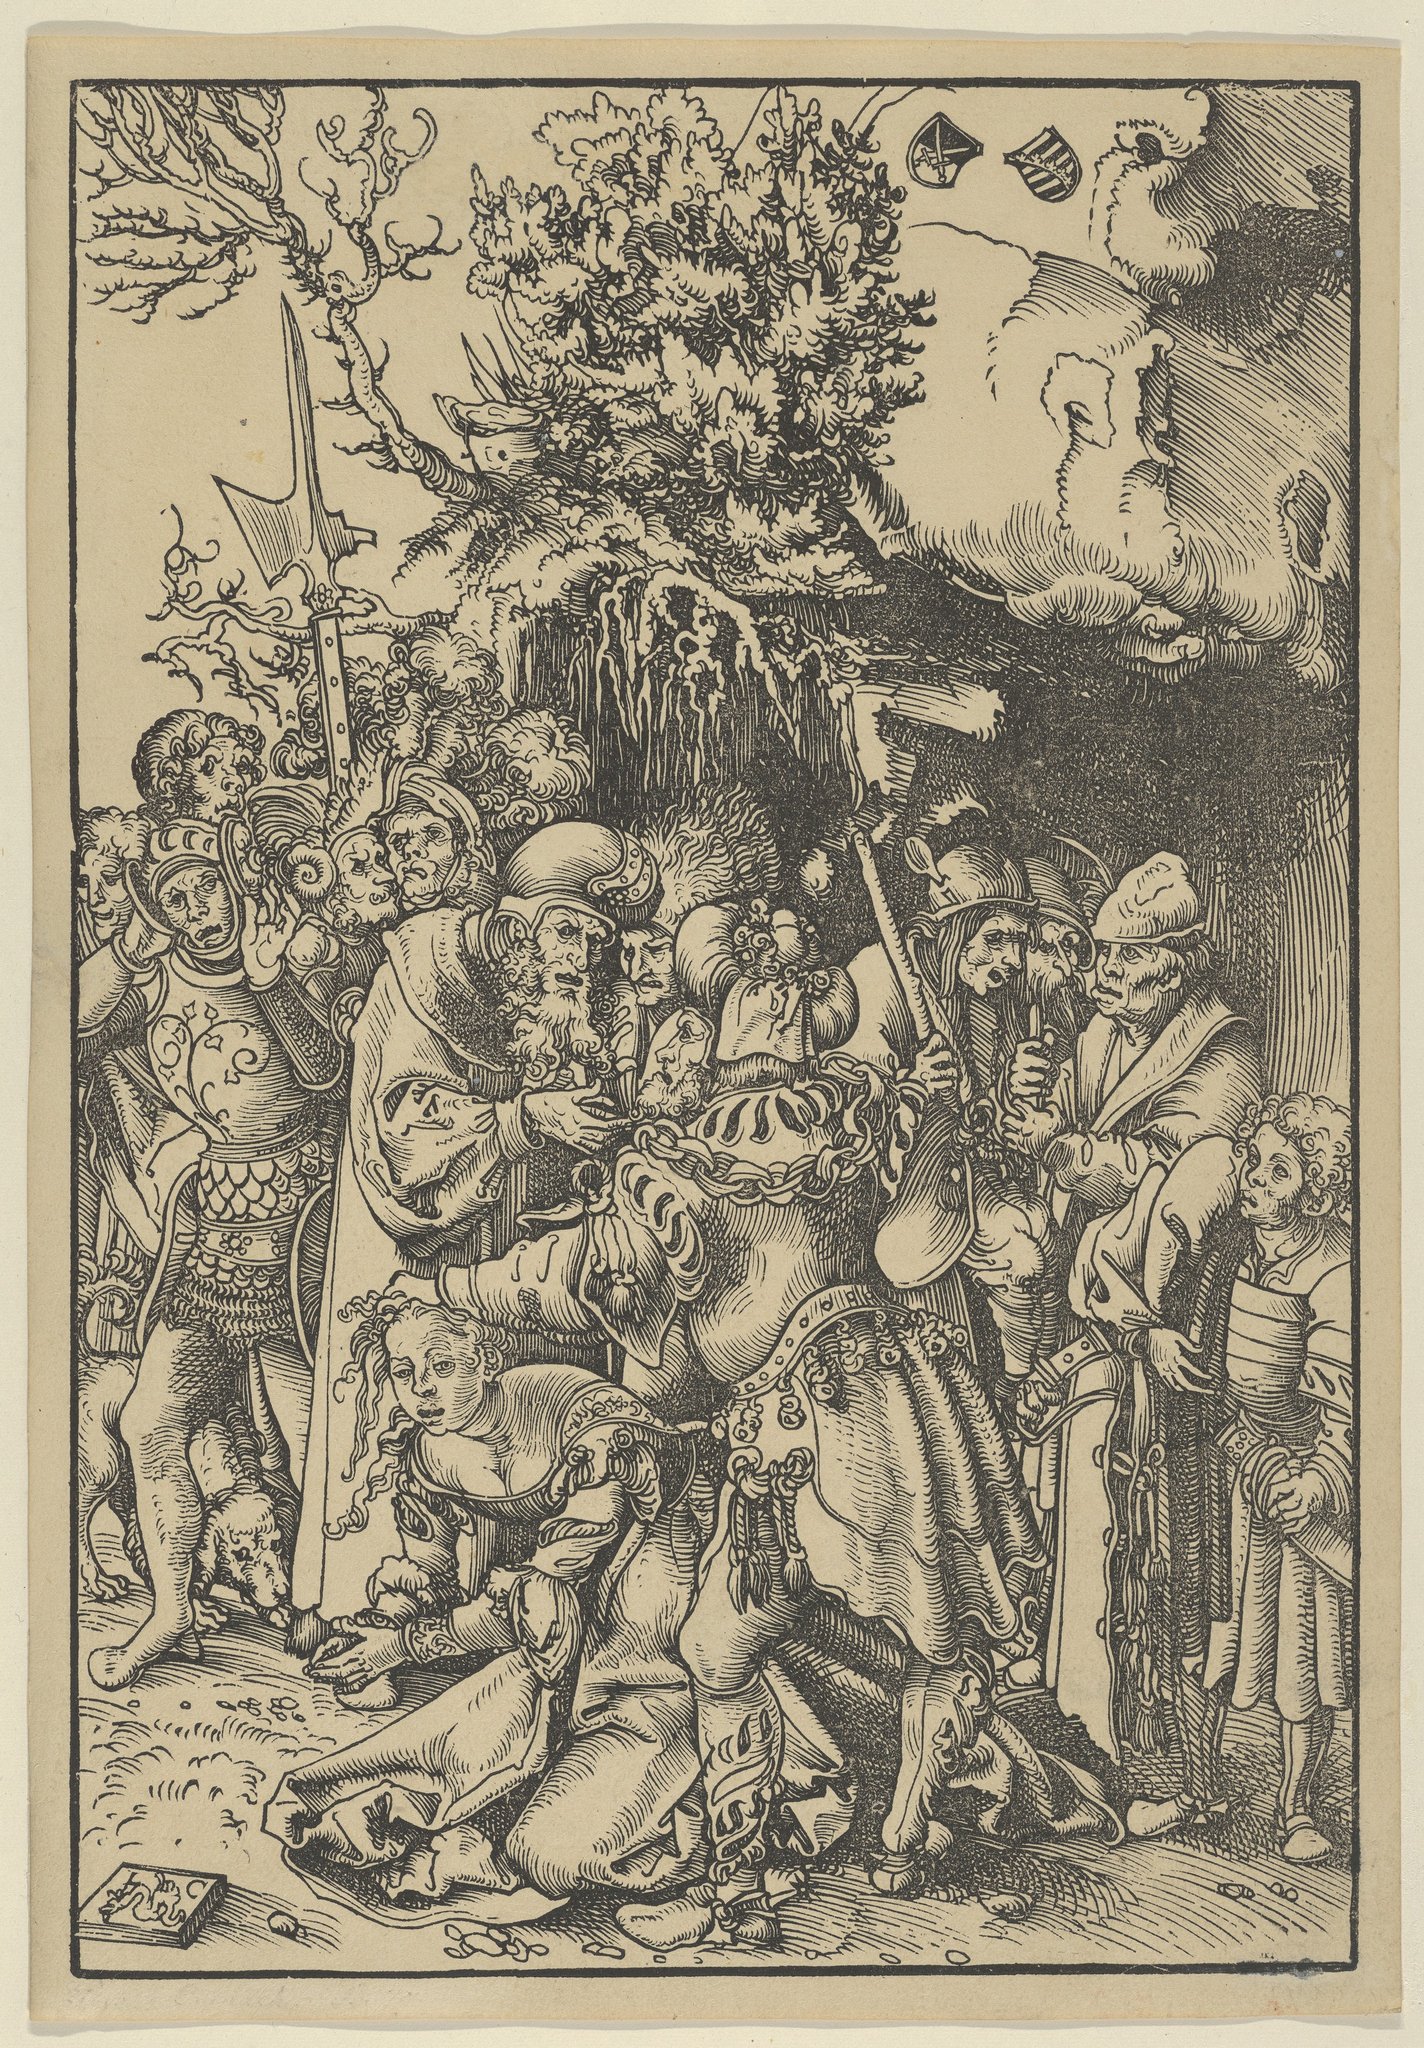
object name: print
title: The Martyrdom of St. Barbara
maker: lucas cranach the elder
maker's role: artist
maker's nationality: german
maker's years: 1472-1553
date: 1472-1553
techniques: woodcut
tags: soldiers,suffering,men,women,saints